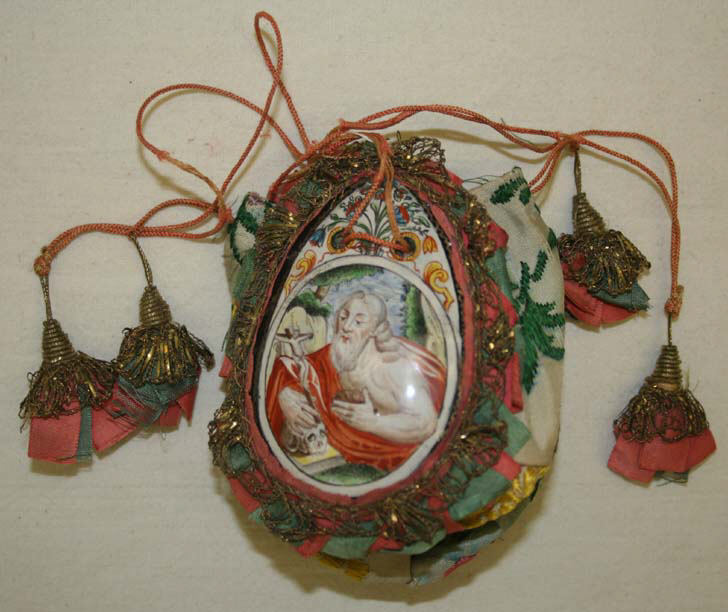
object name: bag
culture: french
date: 1667-1700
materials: copper, silk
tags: skulls,jesus